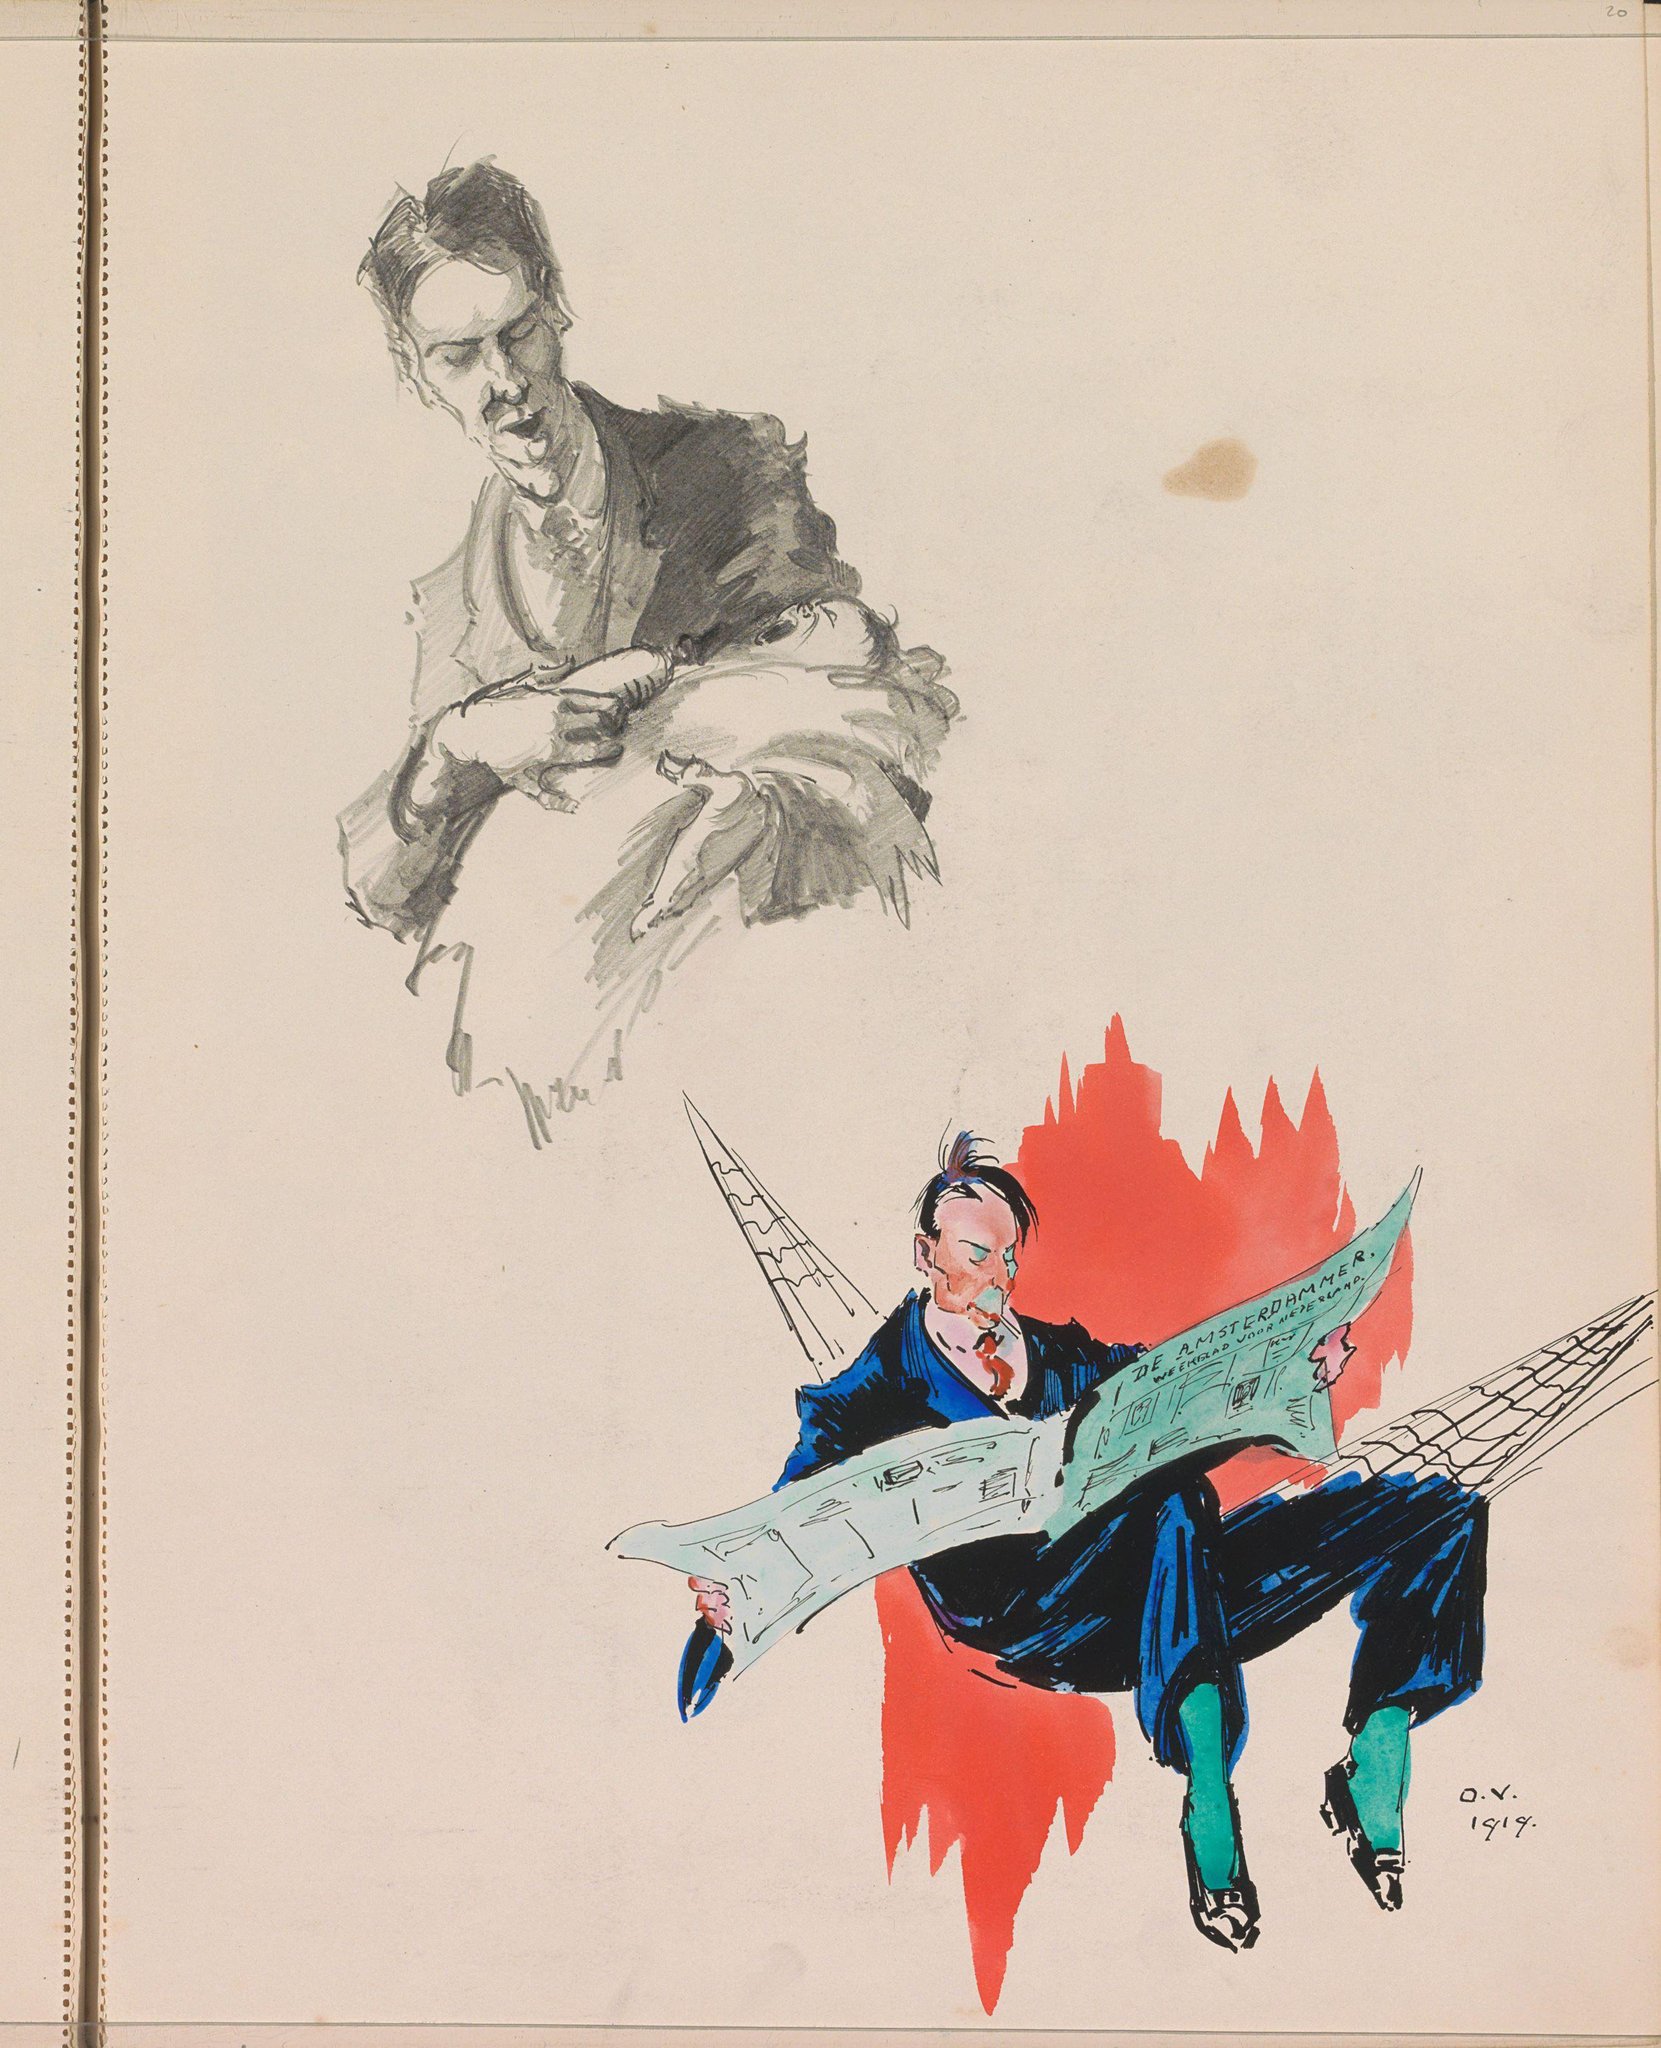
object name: sketchbook leaf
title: Man met een baby op de arm en een man die de krant leest in een hangmat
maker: otto verhagen (i)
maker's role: draughtsman, print maker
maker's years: 1885-1951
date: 1919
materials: ink, paper, pencil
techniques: brush, pen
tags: hammock, reading, feeding a baby, newspaper, news-sheet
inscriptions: signature and date: ‘o.v./ 1919.’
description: De man probeert de baby de fles te geven. Pagina 20 uit een schetsboek met 28 bladen.